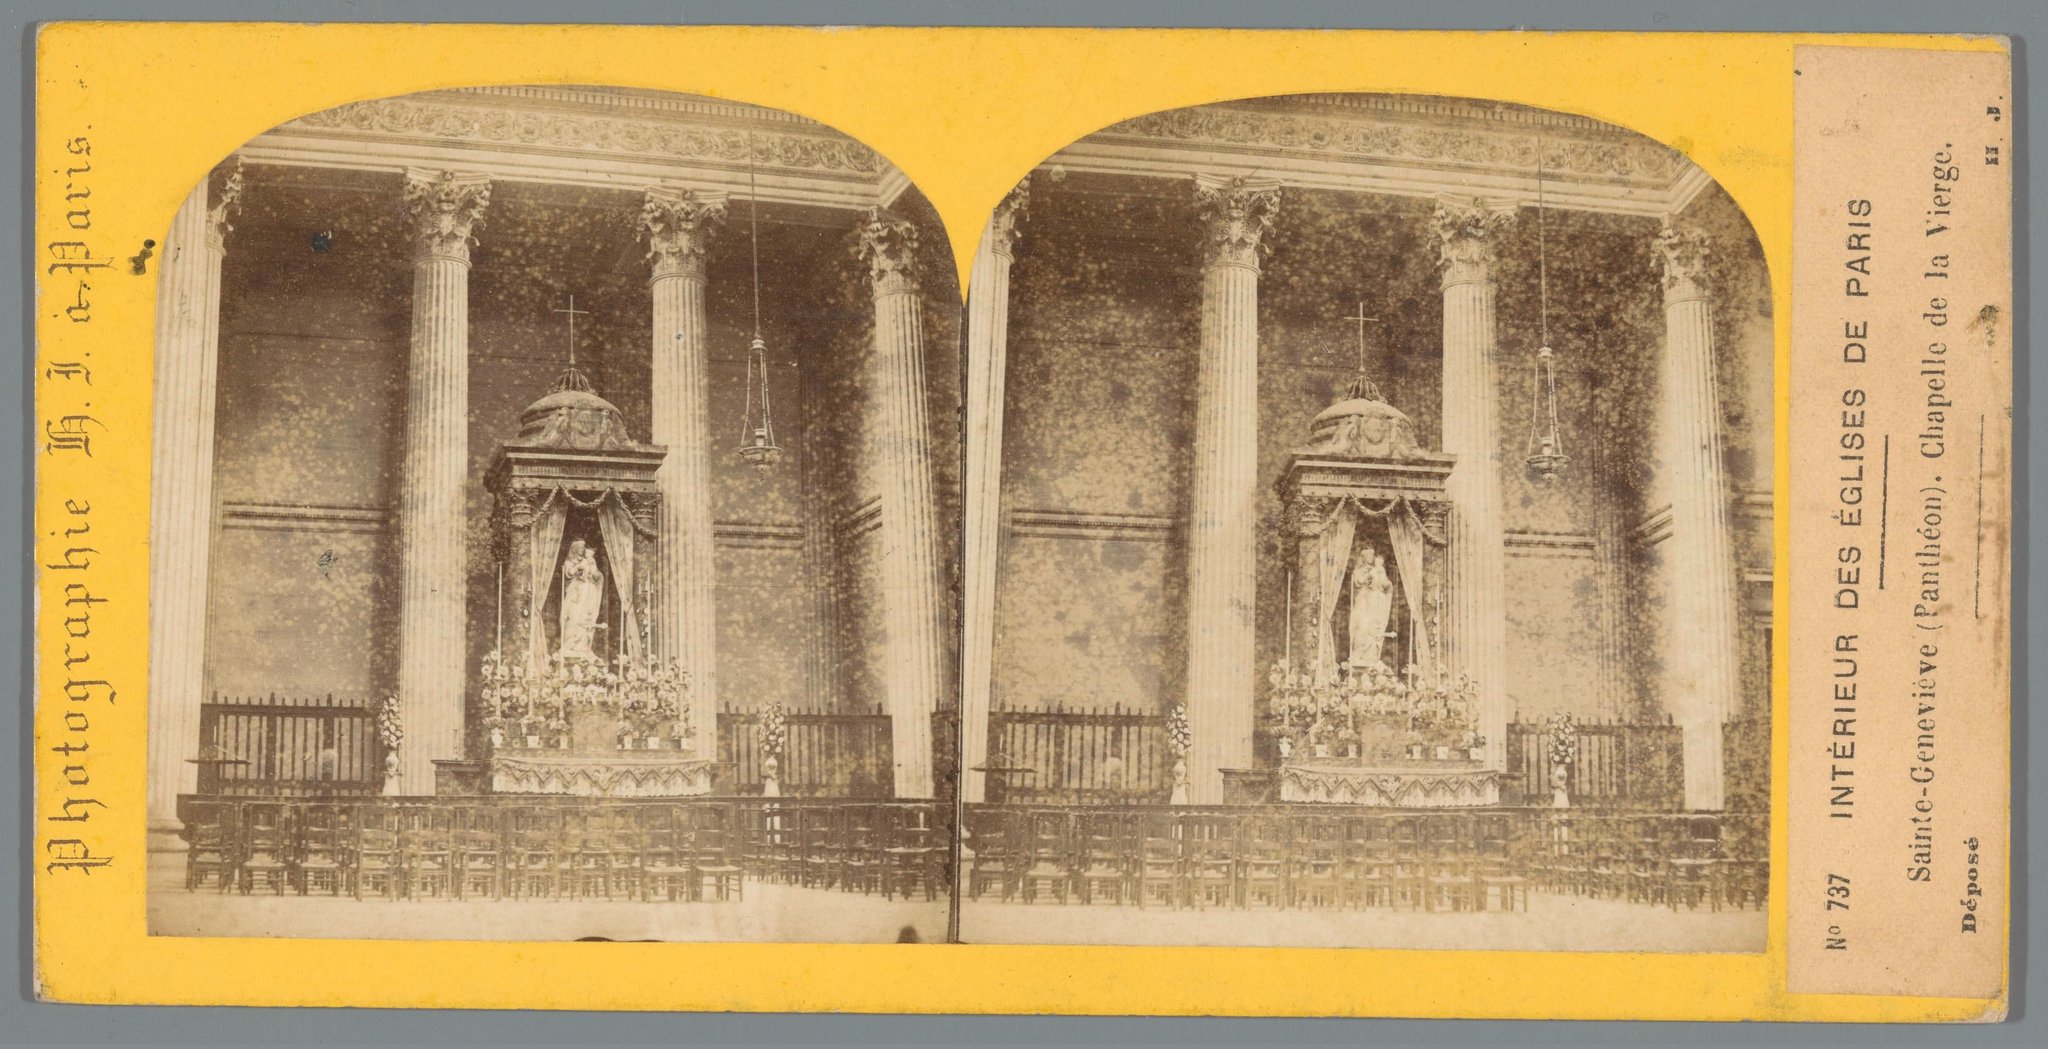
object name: stereograph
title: Interieur van het Panthéon in Parijs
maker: hippolyte jouvin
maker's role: fotograaf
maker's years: 1825-1889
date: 1850-1880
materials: cardboard, photographic support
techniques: albumen print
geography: pantheon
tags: parts of church interior: chapel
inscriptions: number: ‘No 737’